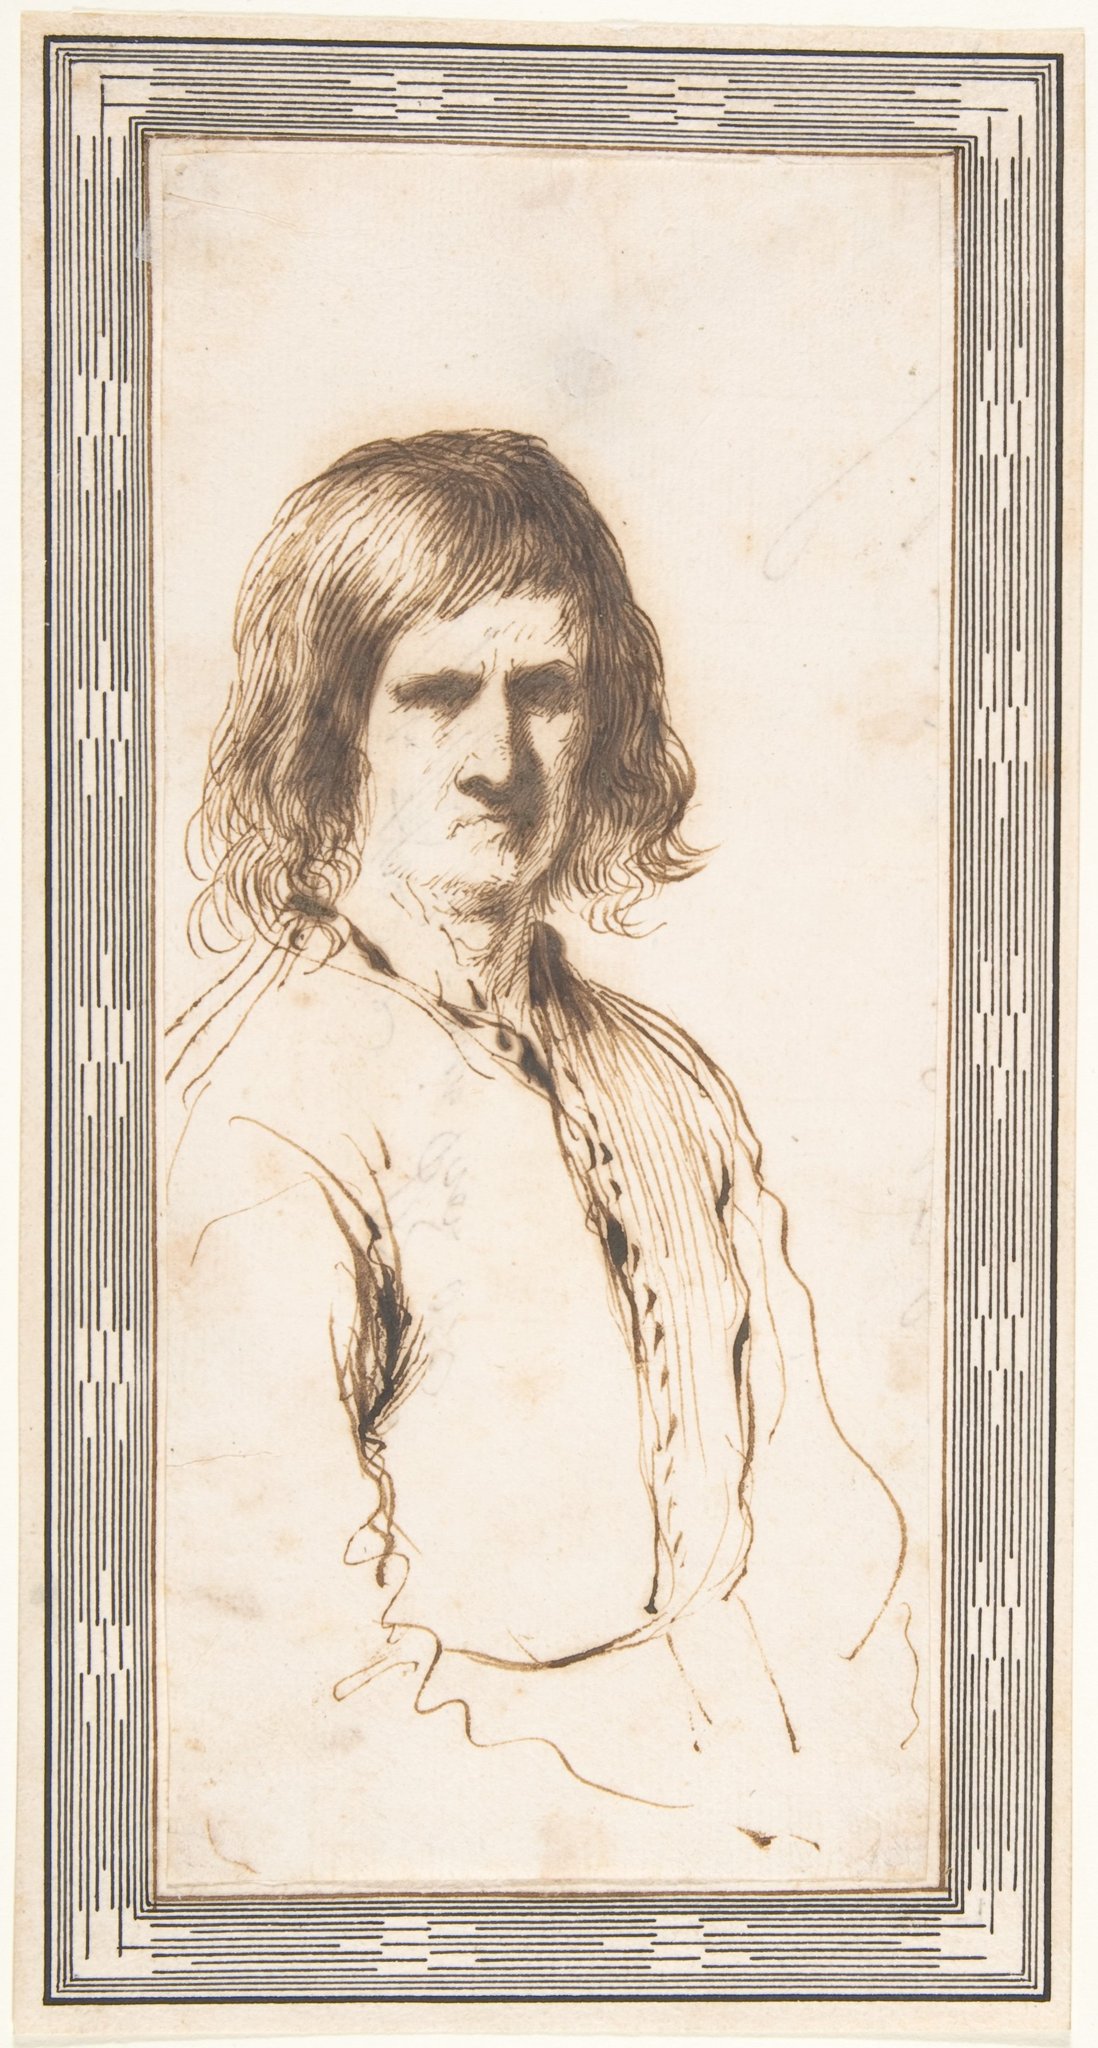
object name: drawing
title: Portrait of Morose Man in Half-Length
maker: guercino (giovanni francesco barbieri)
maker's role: artist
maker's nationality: italian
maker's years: 1591-1666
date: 1591-1666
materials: ink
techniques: pen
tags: men,portraits